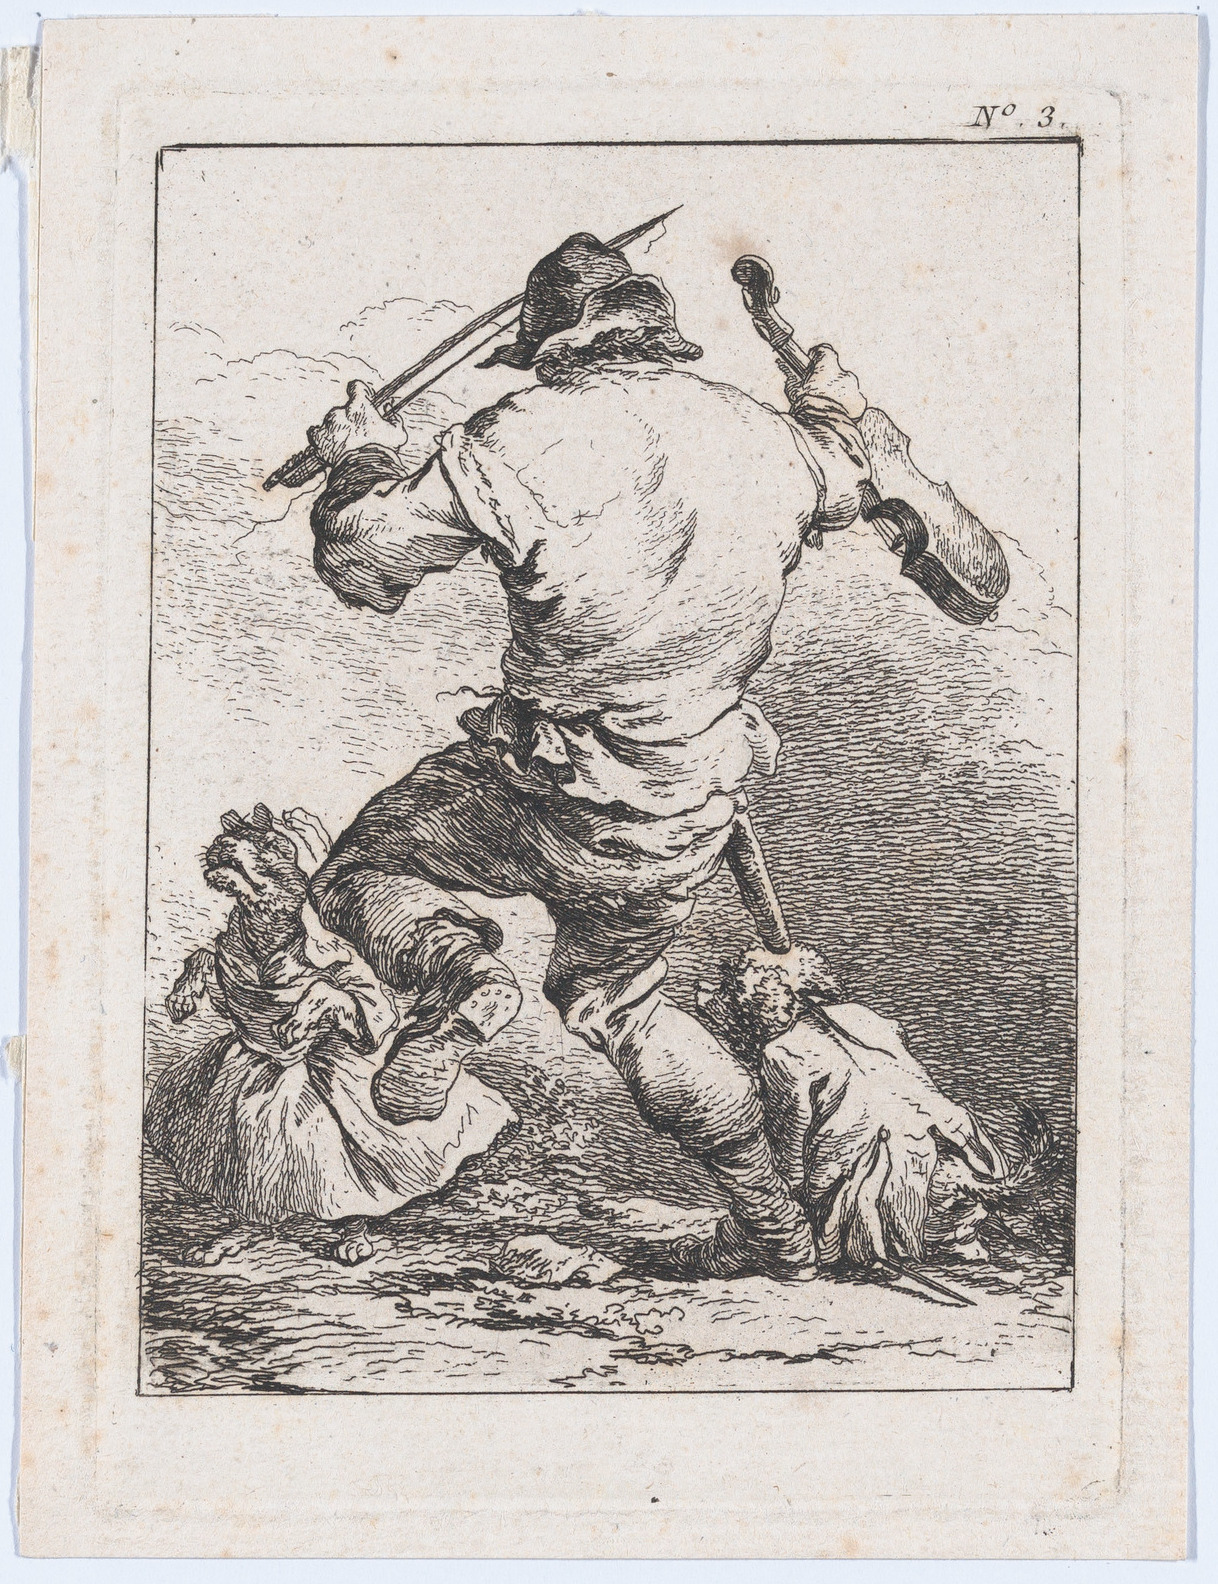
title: Dancing Man, Holding a Violin, Seen from Behind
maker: philippe jacques de loutherbourg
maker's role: artist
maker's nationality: french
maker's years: 1740-1812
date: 1755-1771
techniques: etching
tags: men,dancing,violins,cats